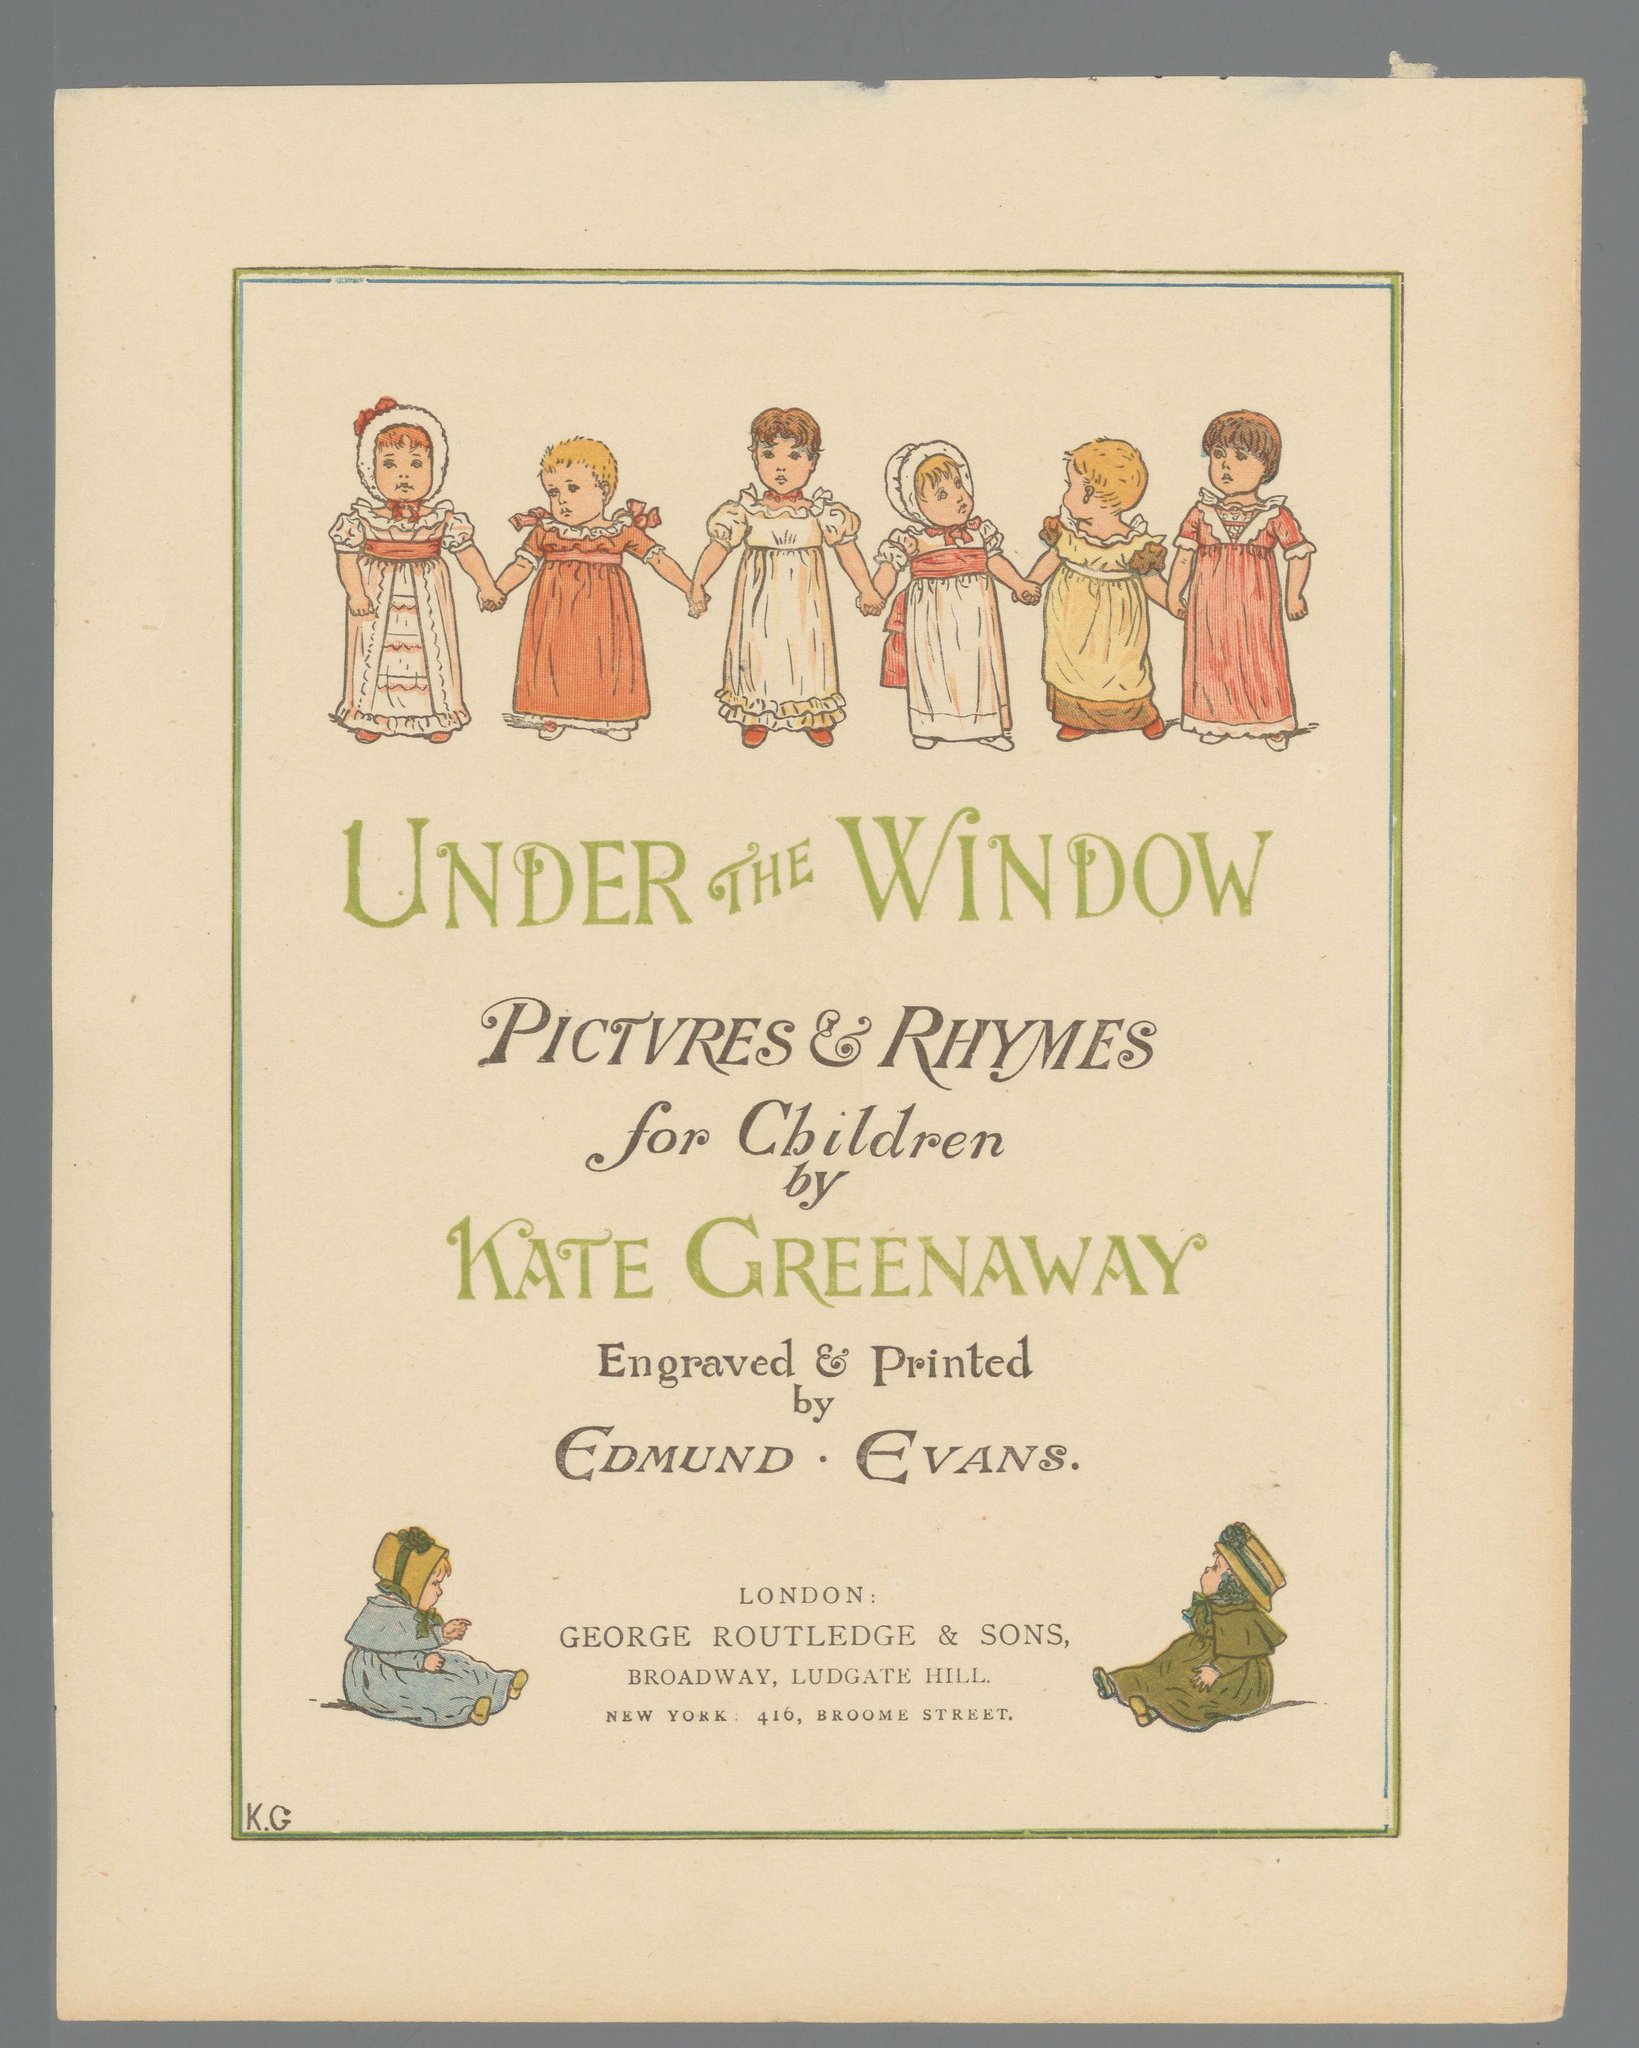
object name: print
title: Under the window, pictures & rhymes for children by Kate Greenaway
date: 1878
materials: paper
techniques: wood engraving, letterpress printing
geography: london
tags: toddler, child, gripping someone by the hand or the wrist; clasped hands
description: Titelpagina voor: Greenaway, Kate. Under the window, pictures & rhymes for children. Londen: George Routledge & Sons, 1878.